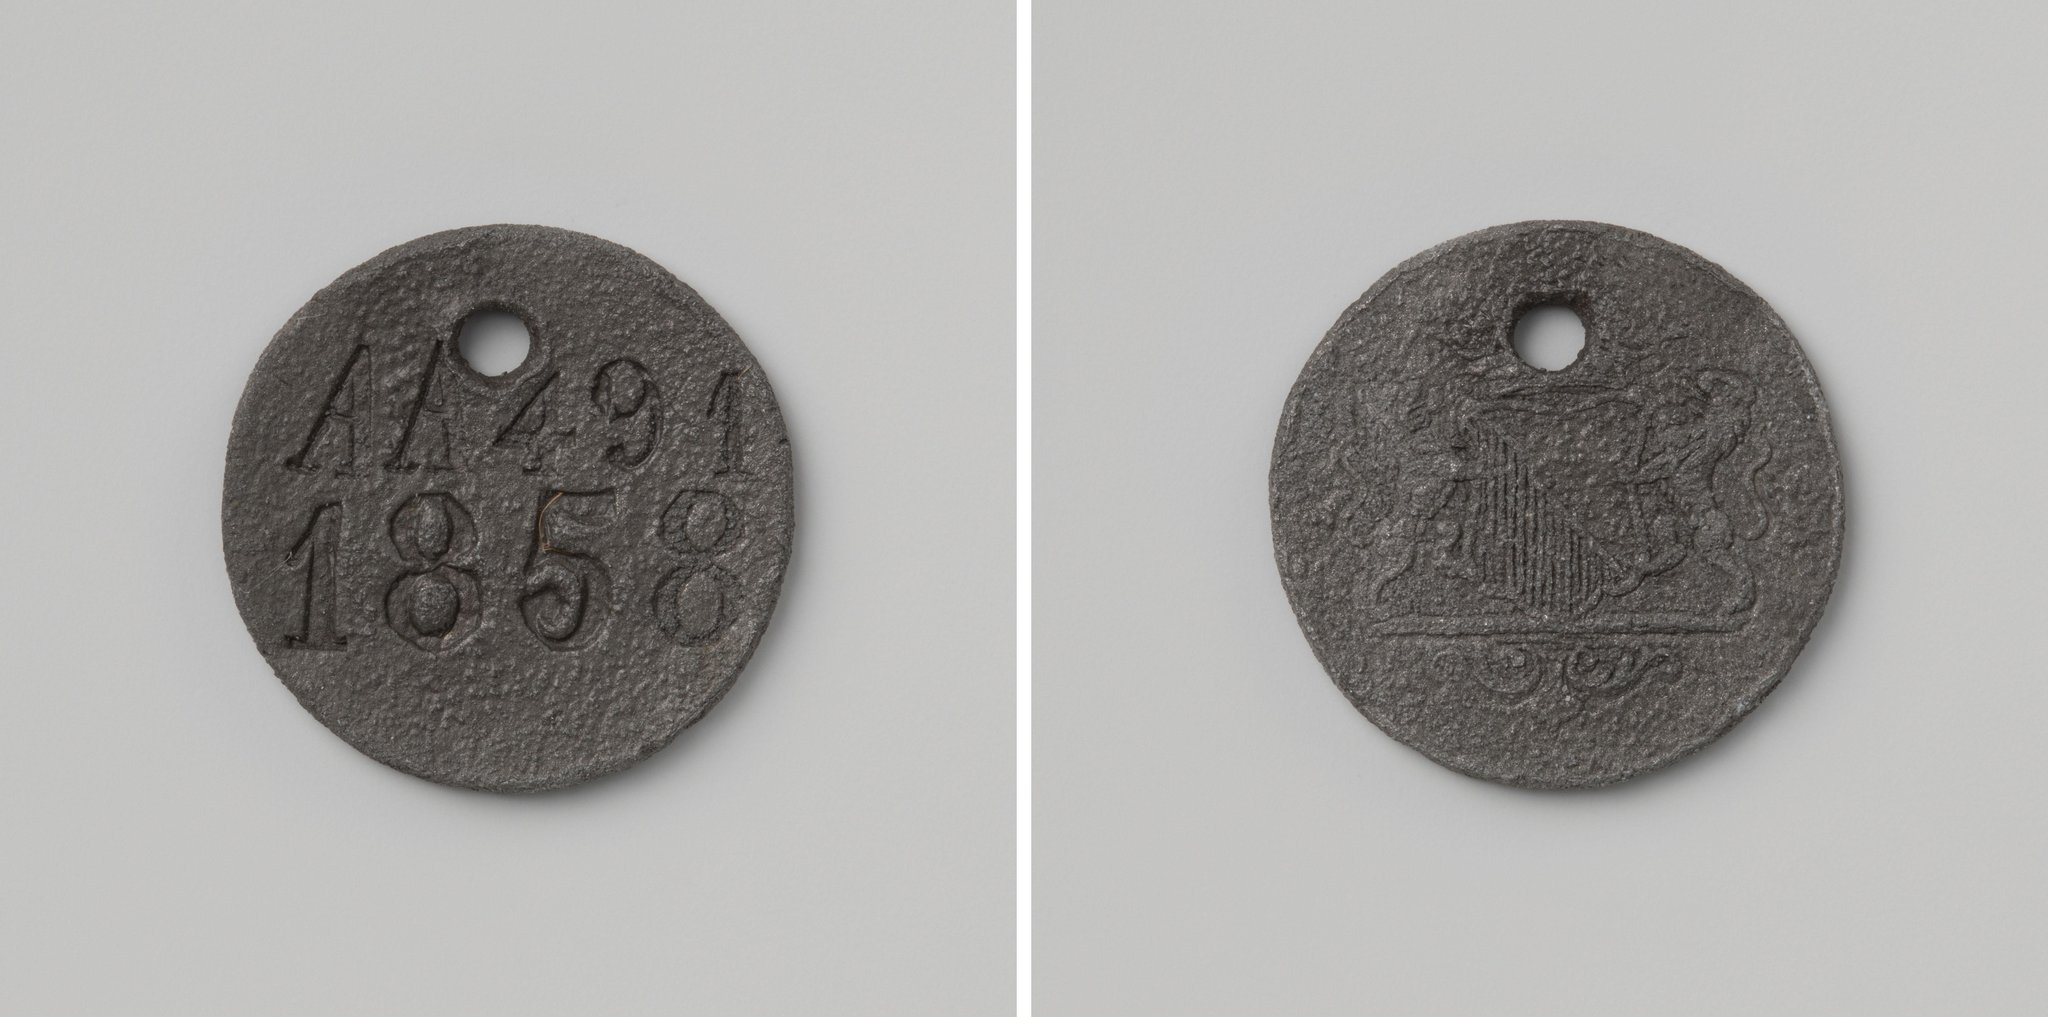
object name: hondenbelastingloodje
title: Stad Utrecht, loodje met no. 164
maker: Anonymous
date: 1864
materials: brass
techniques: striking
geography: utrecht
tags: utrecht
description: rechthoekig loodje met aan bovenzijde ronde hoeken en gat erin aan draagring. Voorzijde: cijfer 164 boven jaartal. Keerzijde: gekroond wapenschild, geflankeerd door twee leeuwen